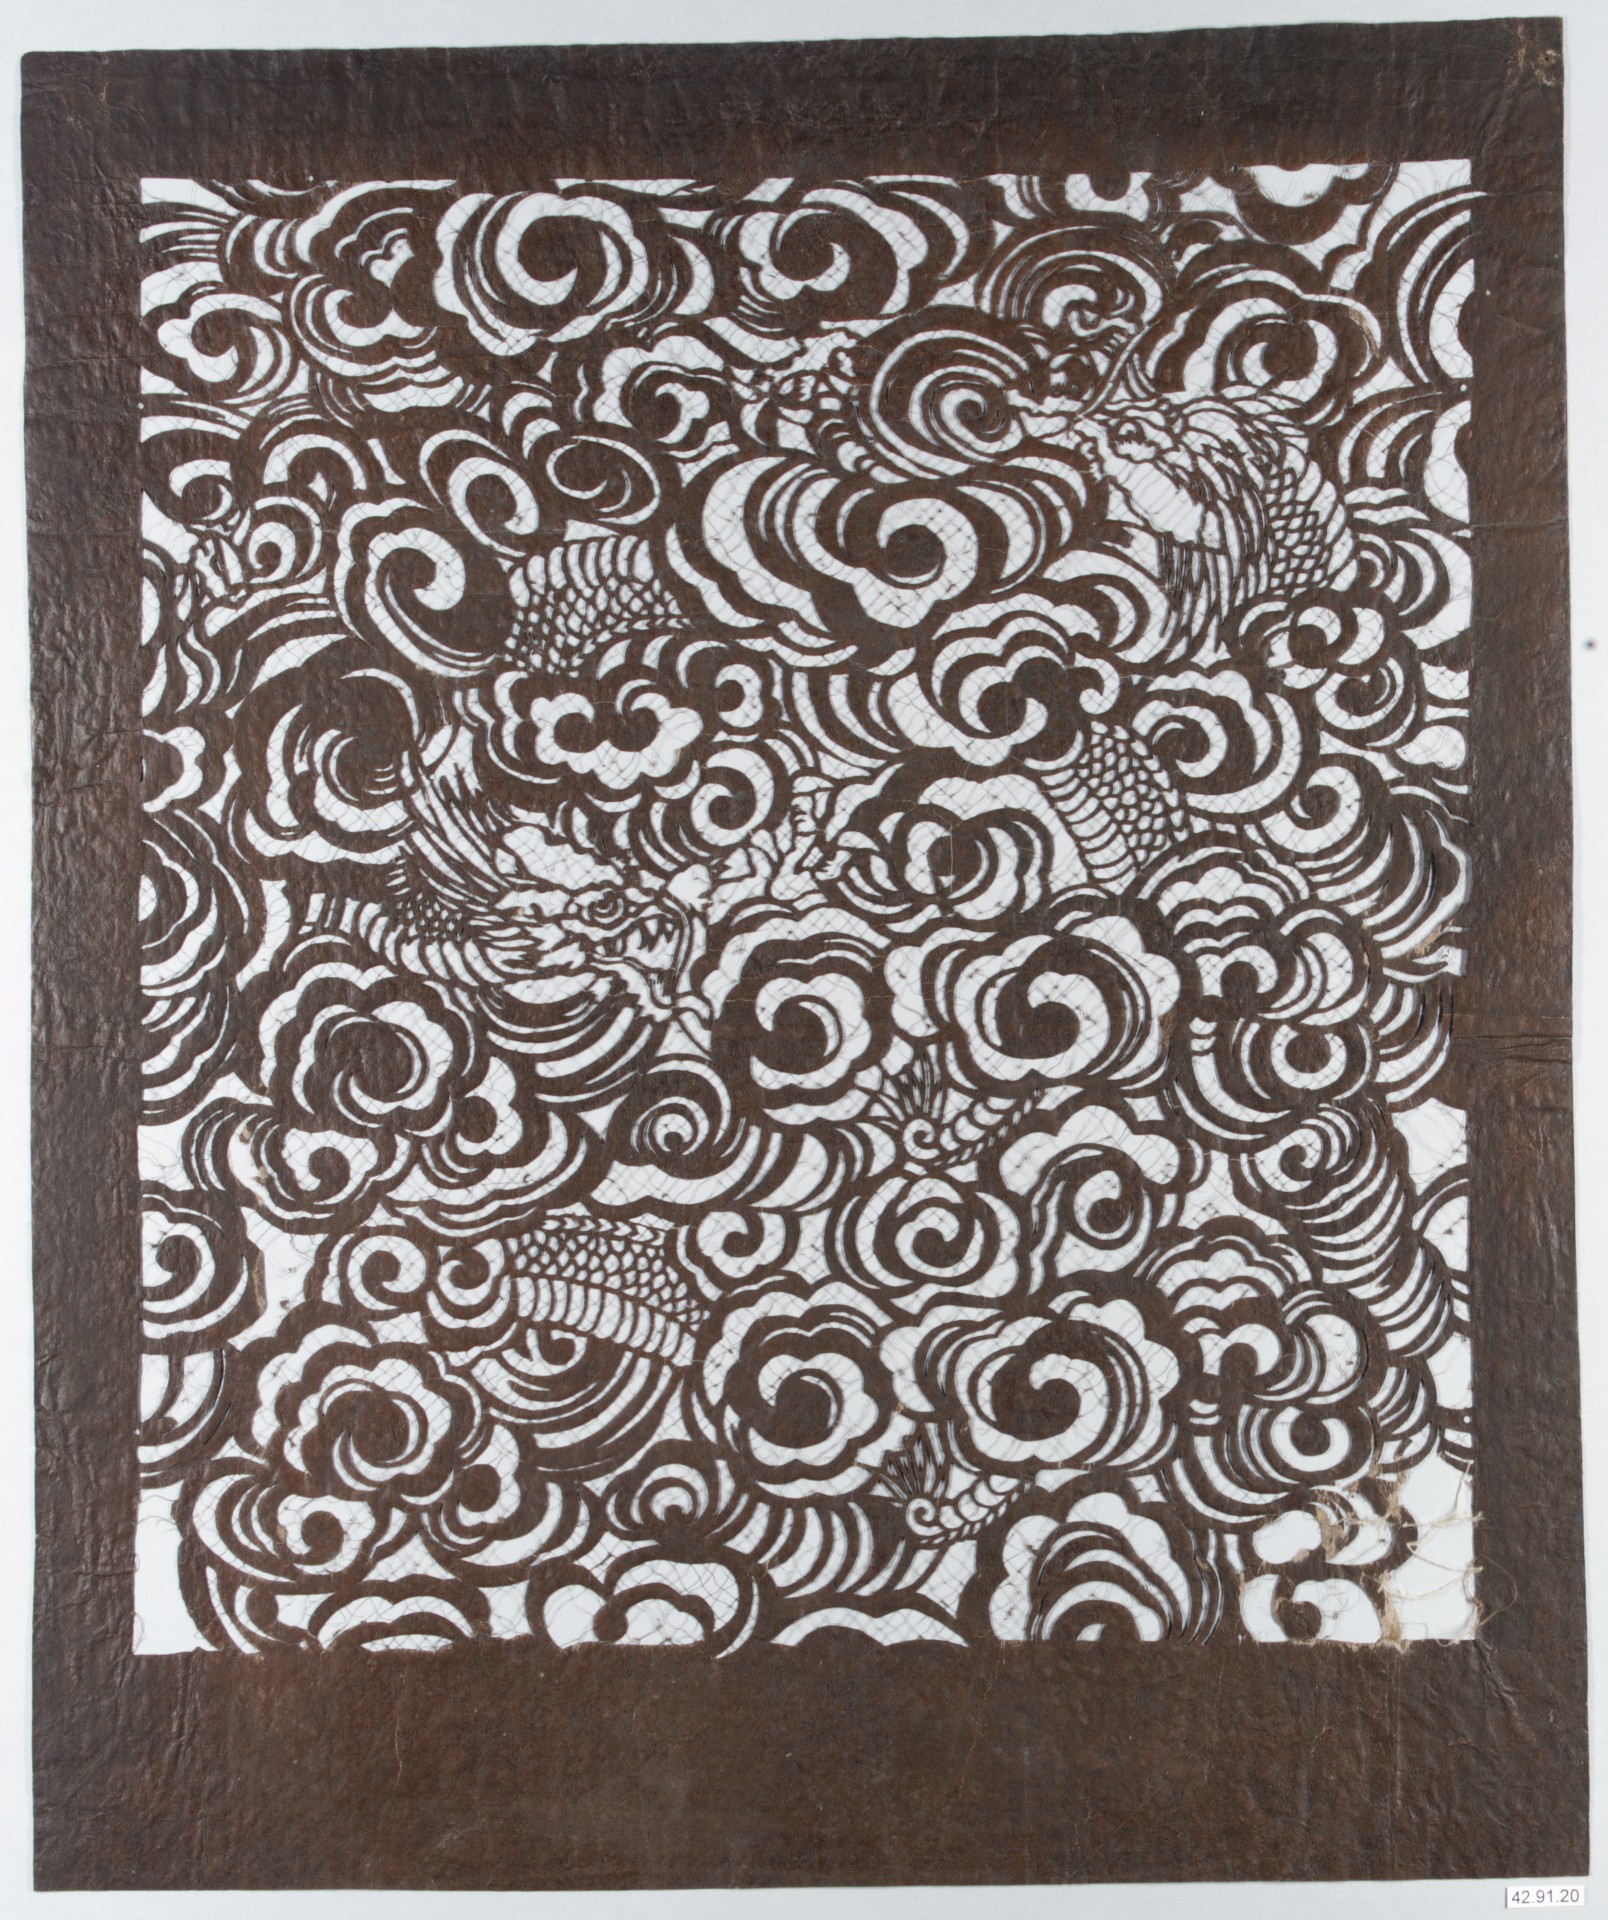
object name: stencil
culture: japanese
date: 1801-1900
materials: paper, silk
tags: dragons,clouds